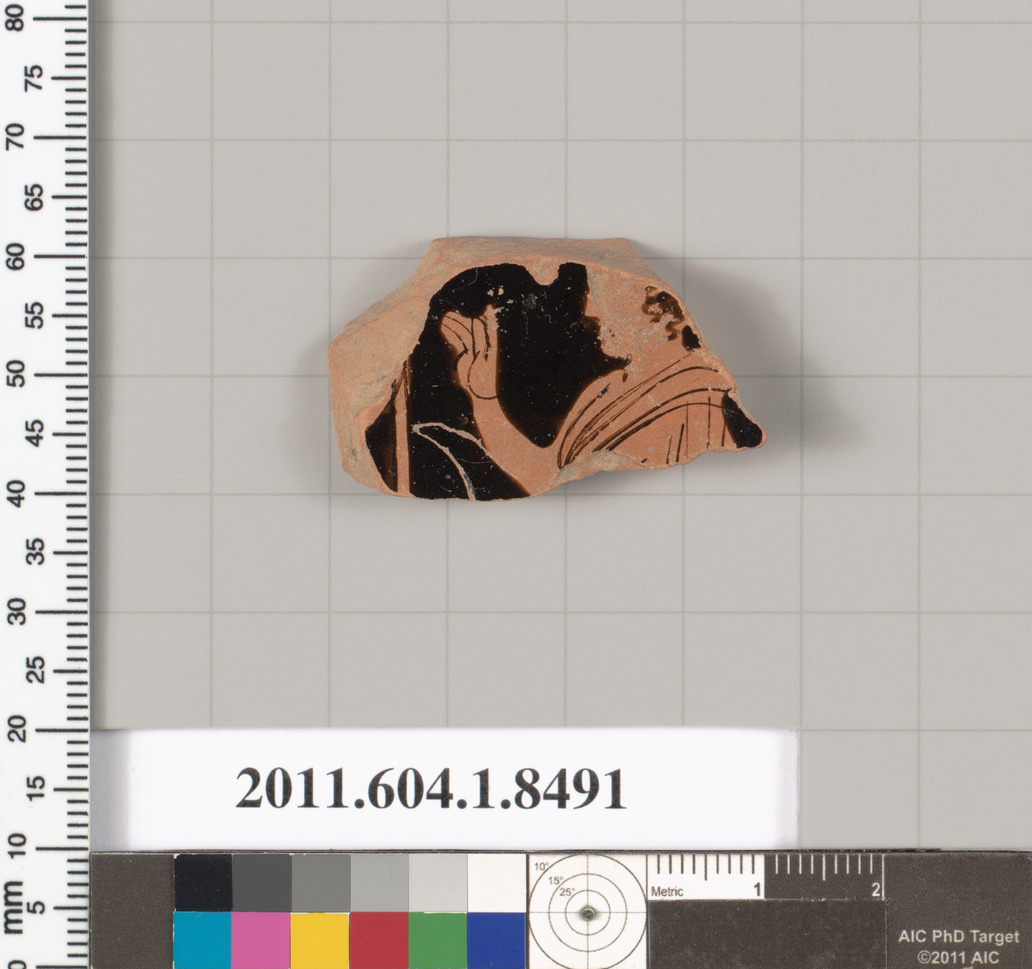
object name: kylix fragment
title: Terracotta fragment of a stemless kylix (drinking cup)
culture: greek, attic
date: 467-435 BCE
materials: terracotta